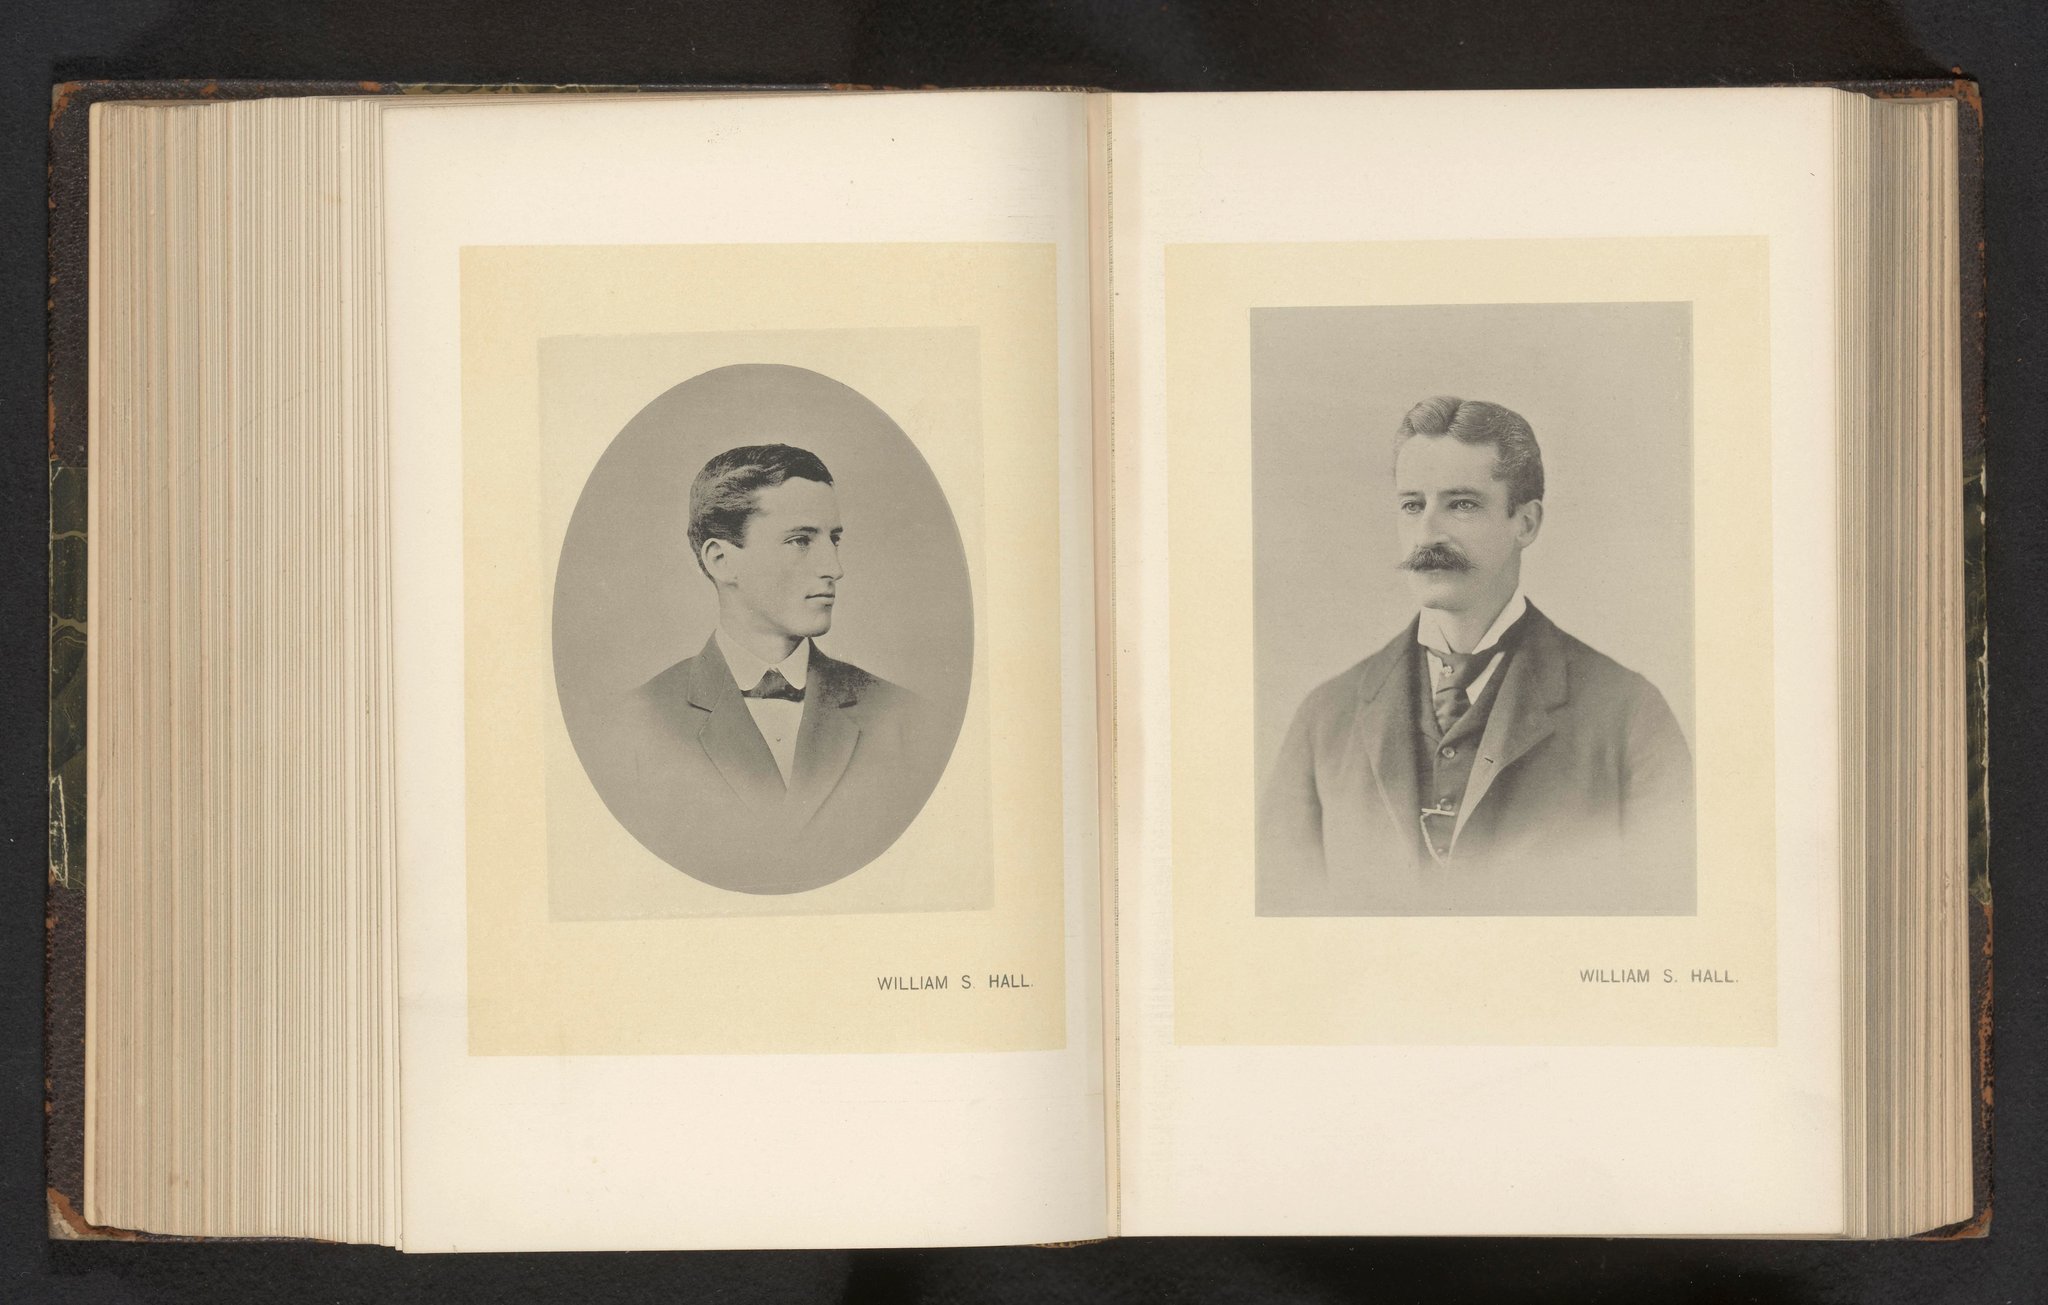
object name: photomechanical print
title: William S. Hall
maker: Anonymous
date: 1869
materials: paper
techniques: photoaquatint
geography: boston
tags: adult man